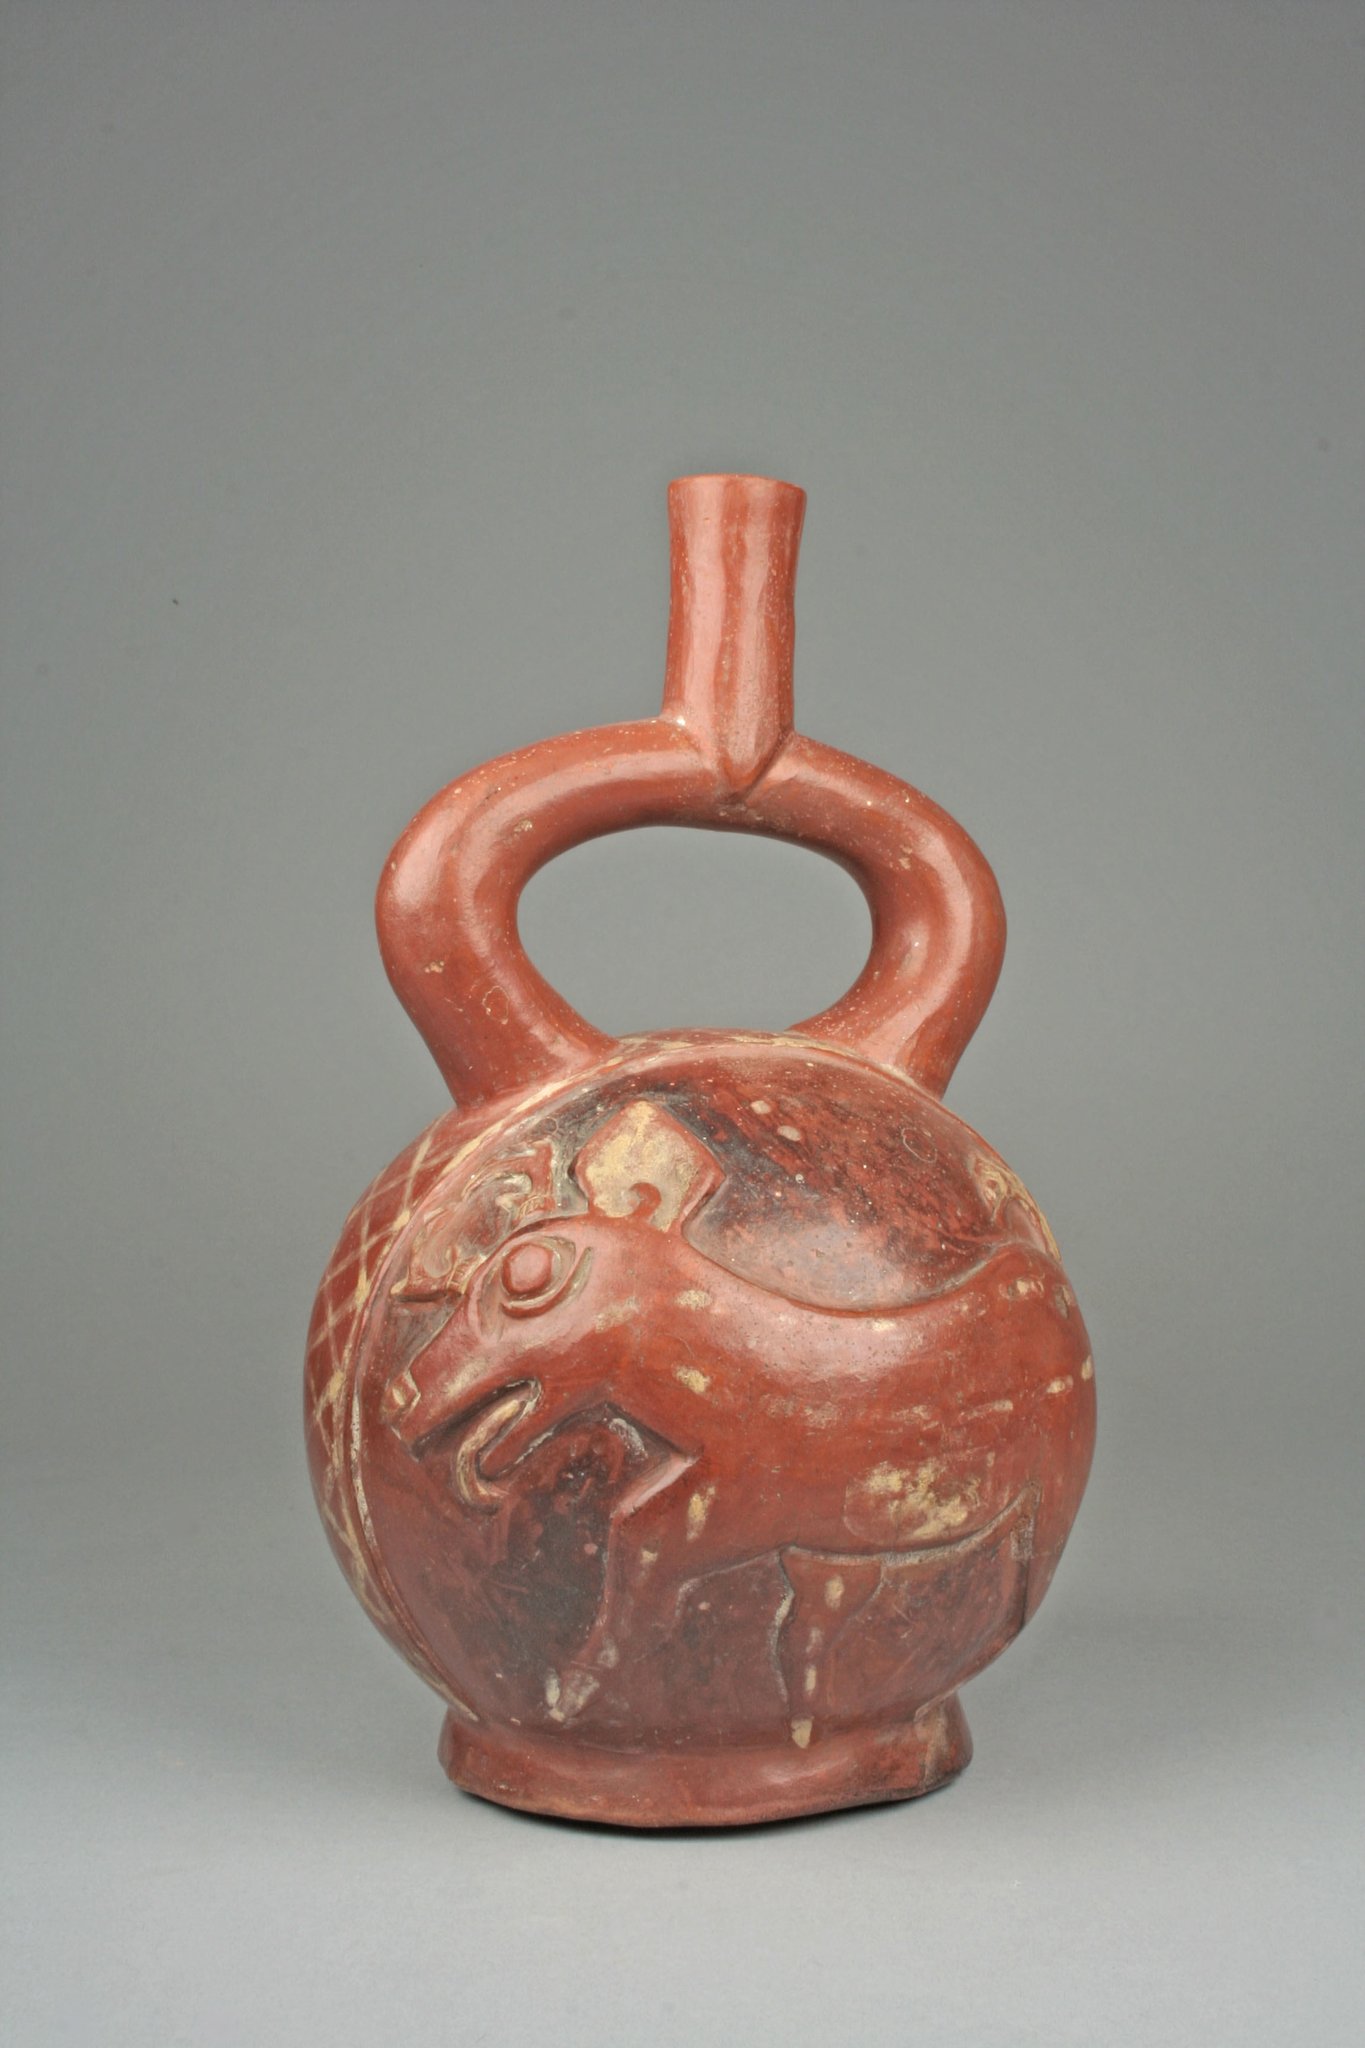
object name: bottle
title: Stirrup Spout Bottle with Deer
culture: moche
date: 1-600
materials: ceramic, pigment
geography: peru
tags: deer